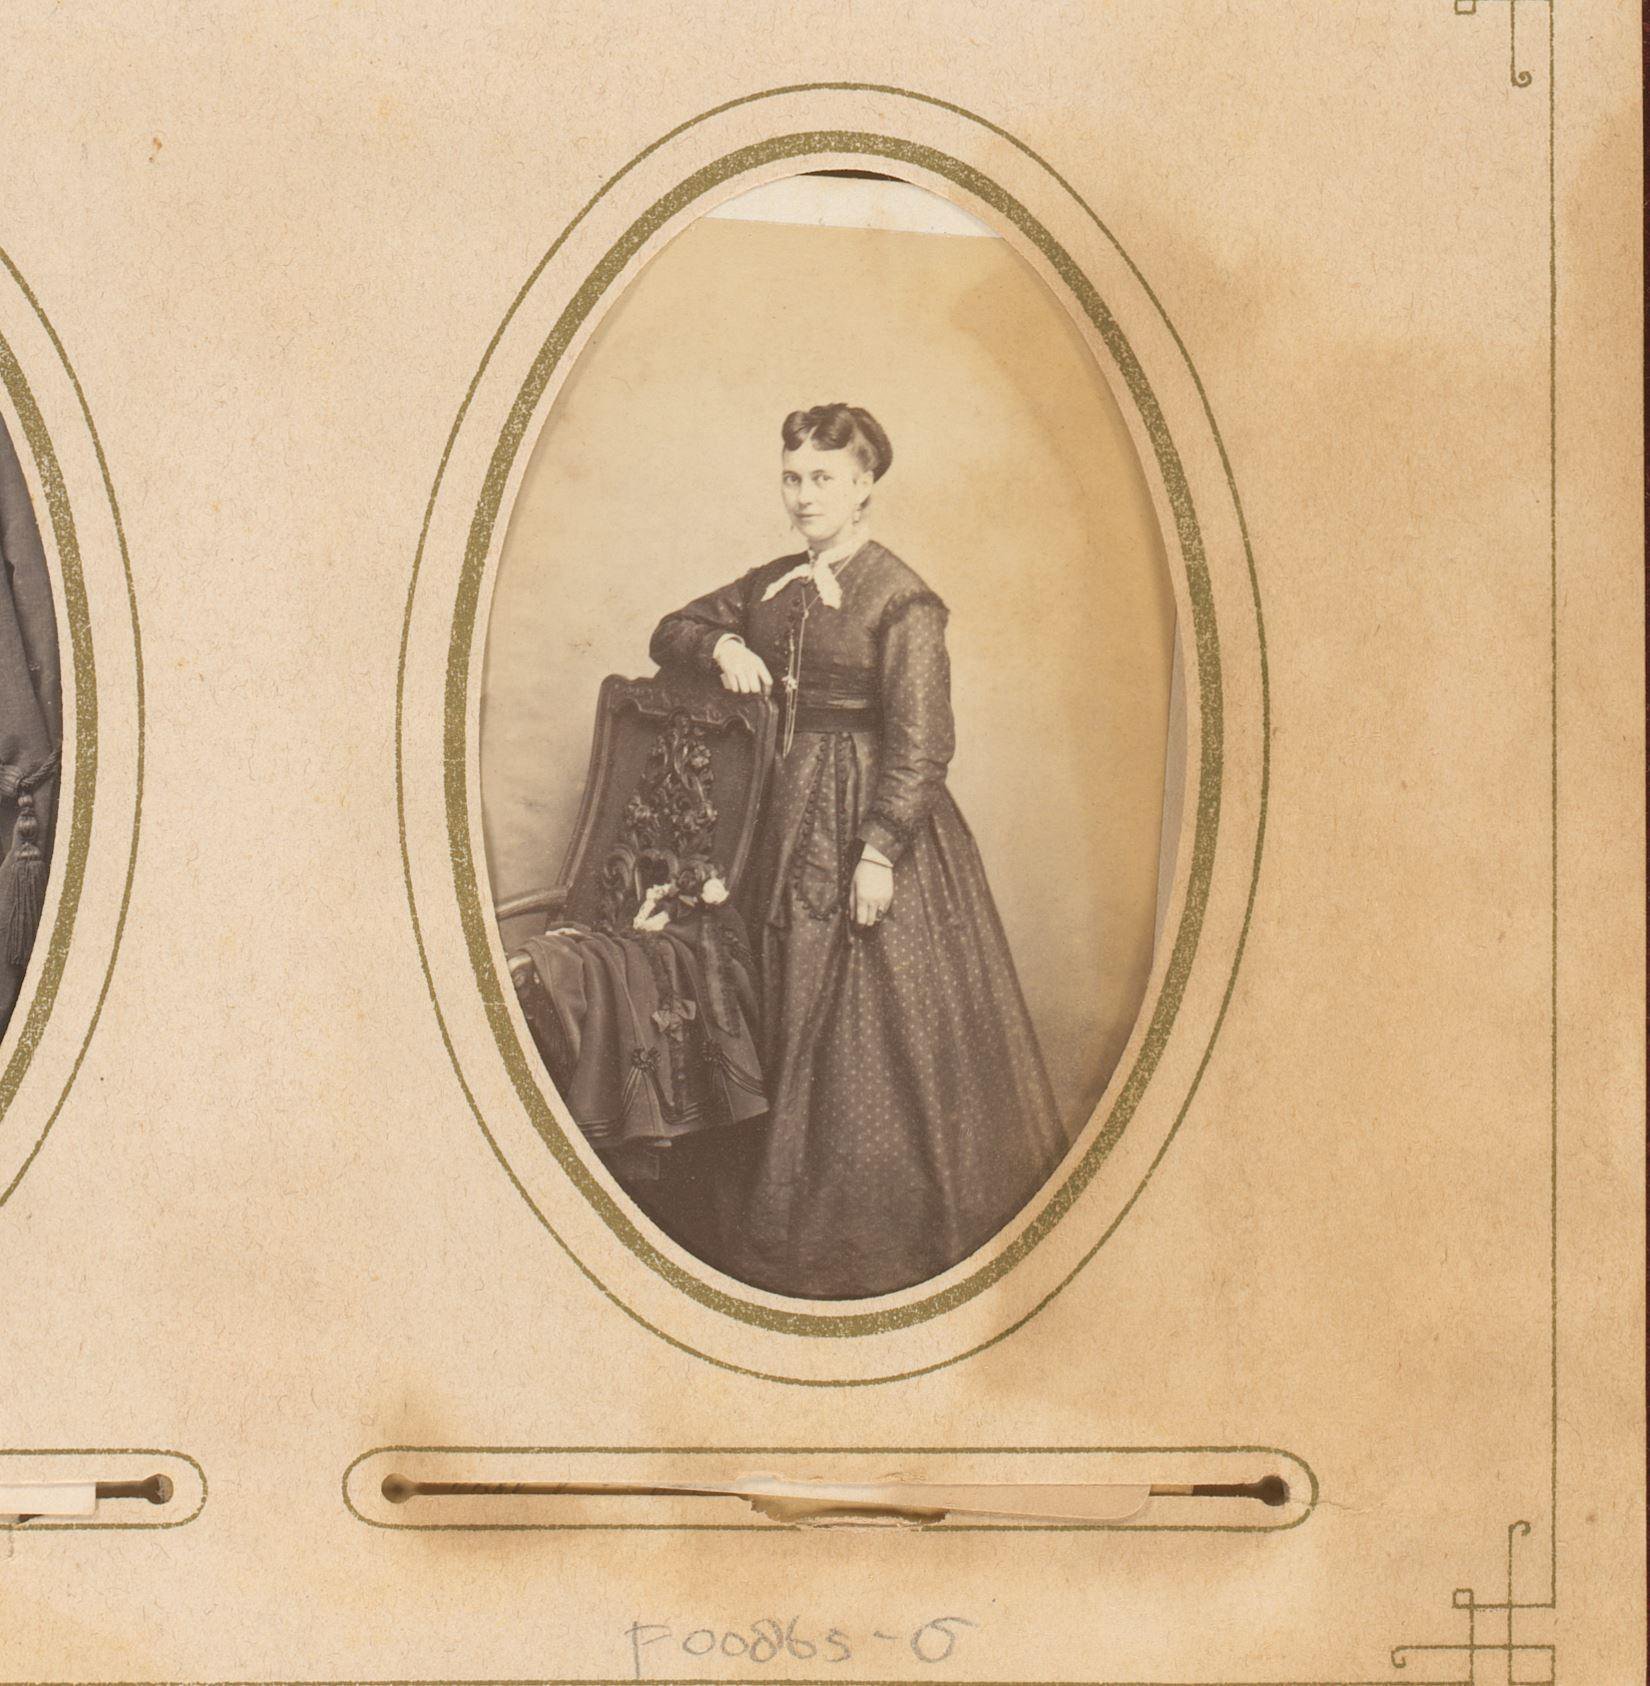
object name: album leaf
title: Portret van een staande vrouw, leunend op stoel met jas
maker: antonius godefridus schull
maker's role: fotograaf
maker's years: 1819-1896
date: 1869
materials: cardboard, photographic support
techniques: albumen print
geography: den bosch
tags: historical persons - bb - woman, standing figure - aa - female human figure, chair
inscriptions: date: ‘1869’, inscription: ‘(...)/ Photographie/ van/ A.G. Schull/ Kerkstraat/ 'S HERTOGENBOSCH.’